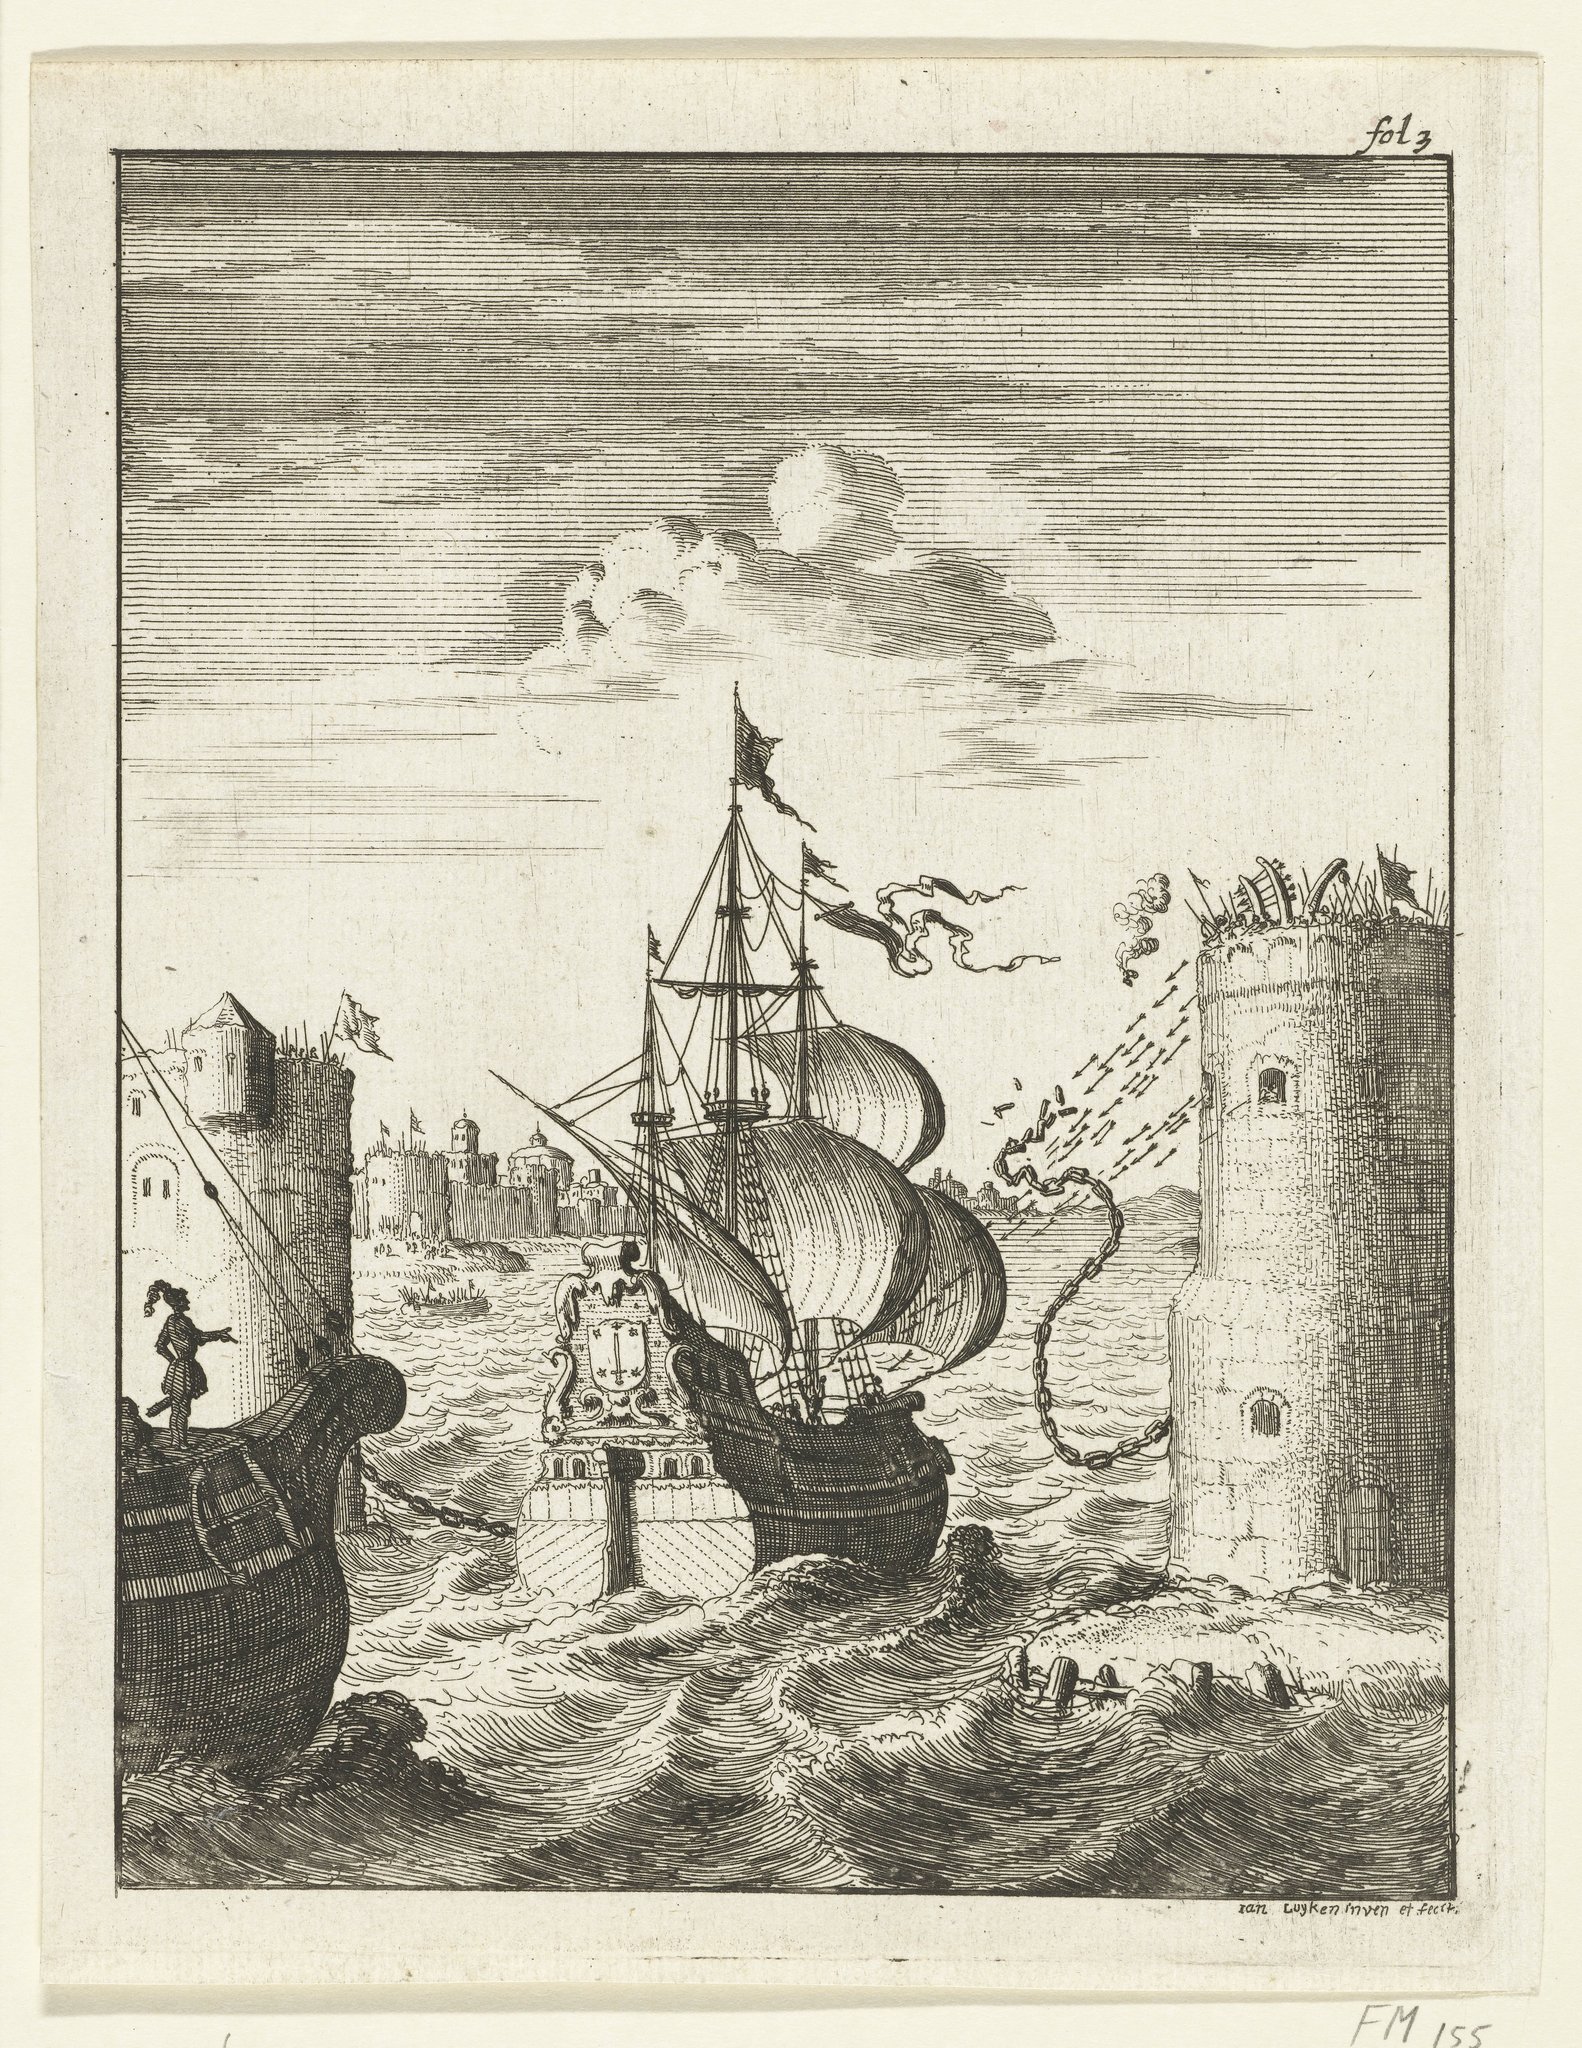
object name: print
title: Verovering van Damiate, 1219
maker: jan luyken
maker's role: draughtsman, print maker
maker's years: 1649-1712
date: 1680-1683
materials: paper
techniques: etching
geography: northern netherlands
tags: haarlem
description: Illustratie voor: Lambert van den Bos, Leeven en daaden der doorluchtigste zee-helden, J. ten Hoorn en J. Bouman, Amsterdam 1683, fol. 3.